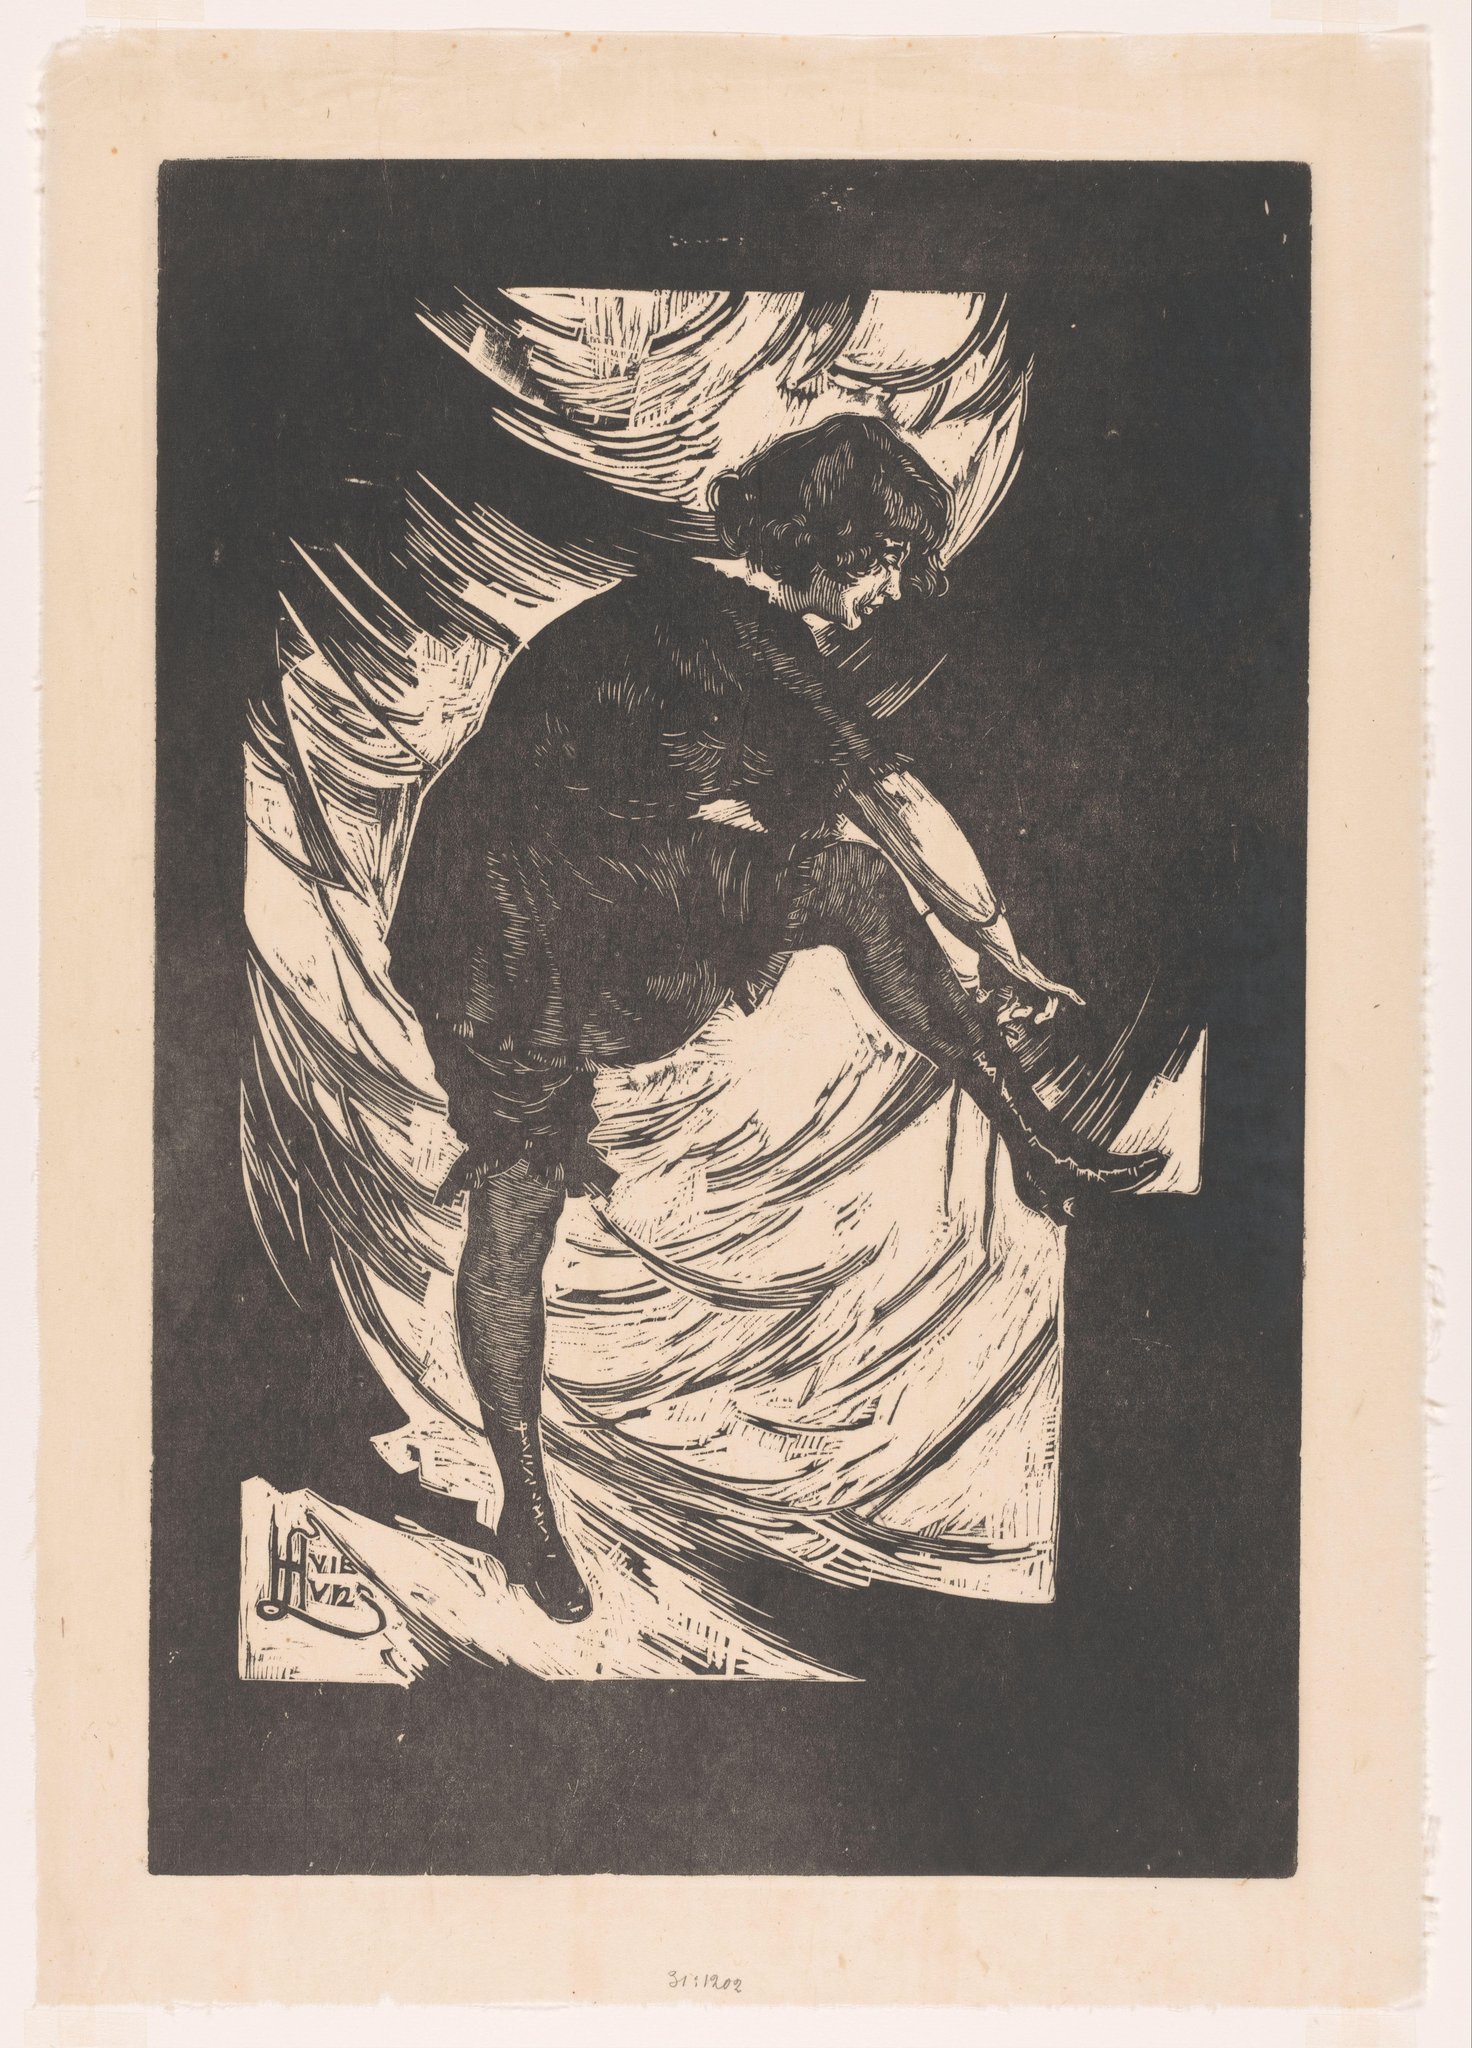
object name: print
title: Jonge vrouw strikt de veters van haar laars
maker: huib luns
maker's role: draughtsman, print maker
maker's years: 1881-1942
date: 1891-1931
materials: paper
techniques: woodcut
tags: adolescent, young woman, maiden, boots